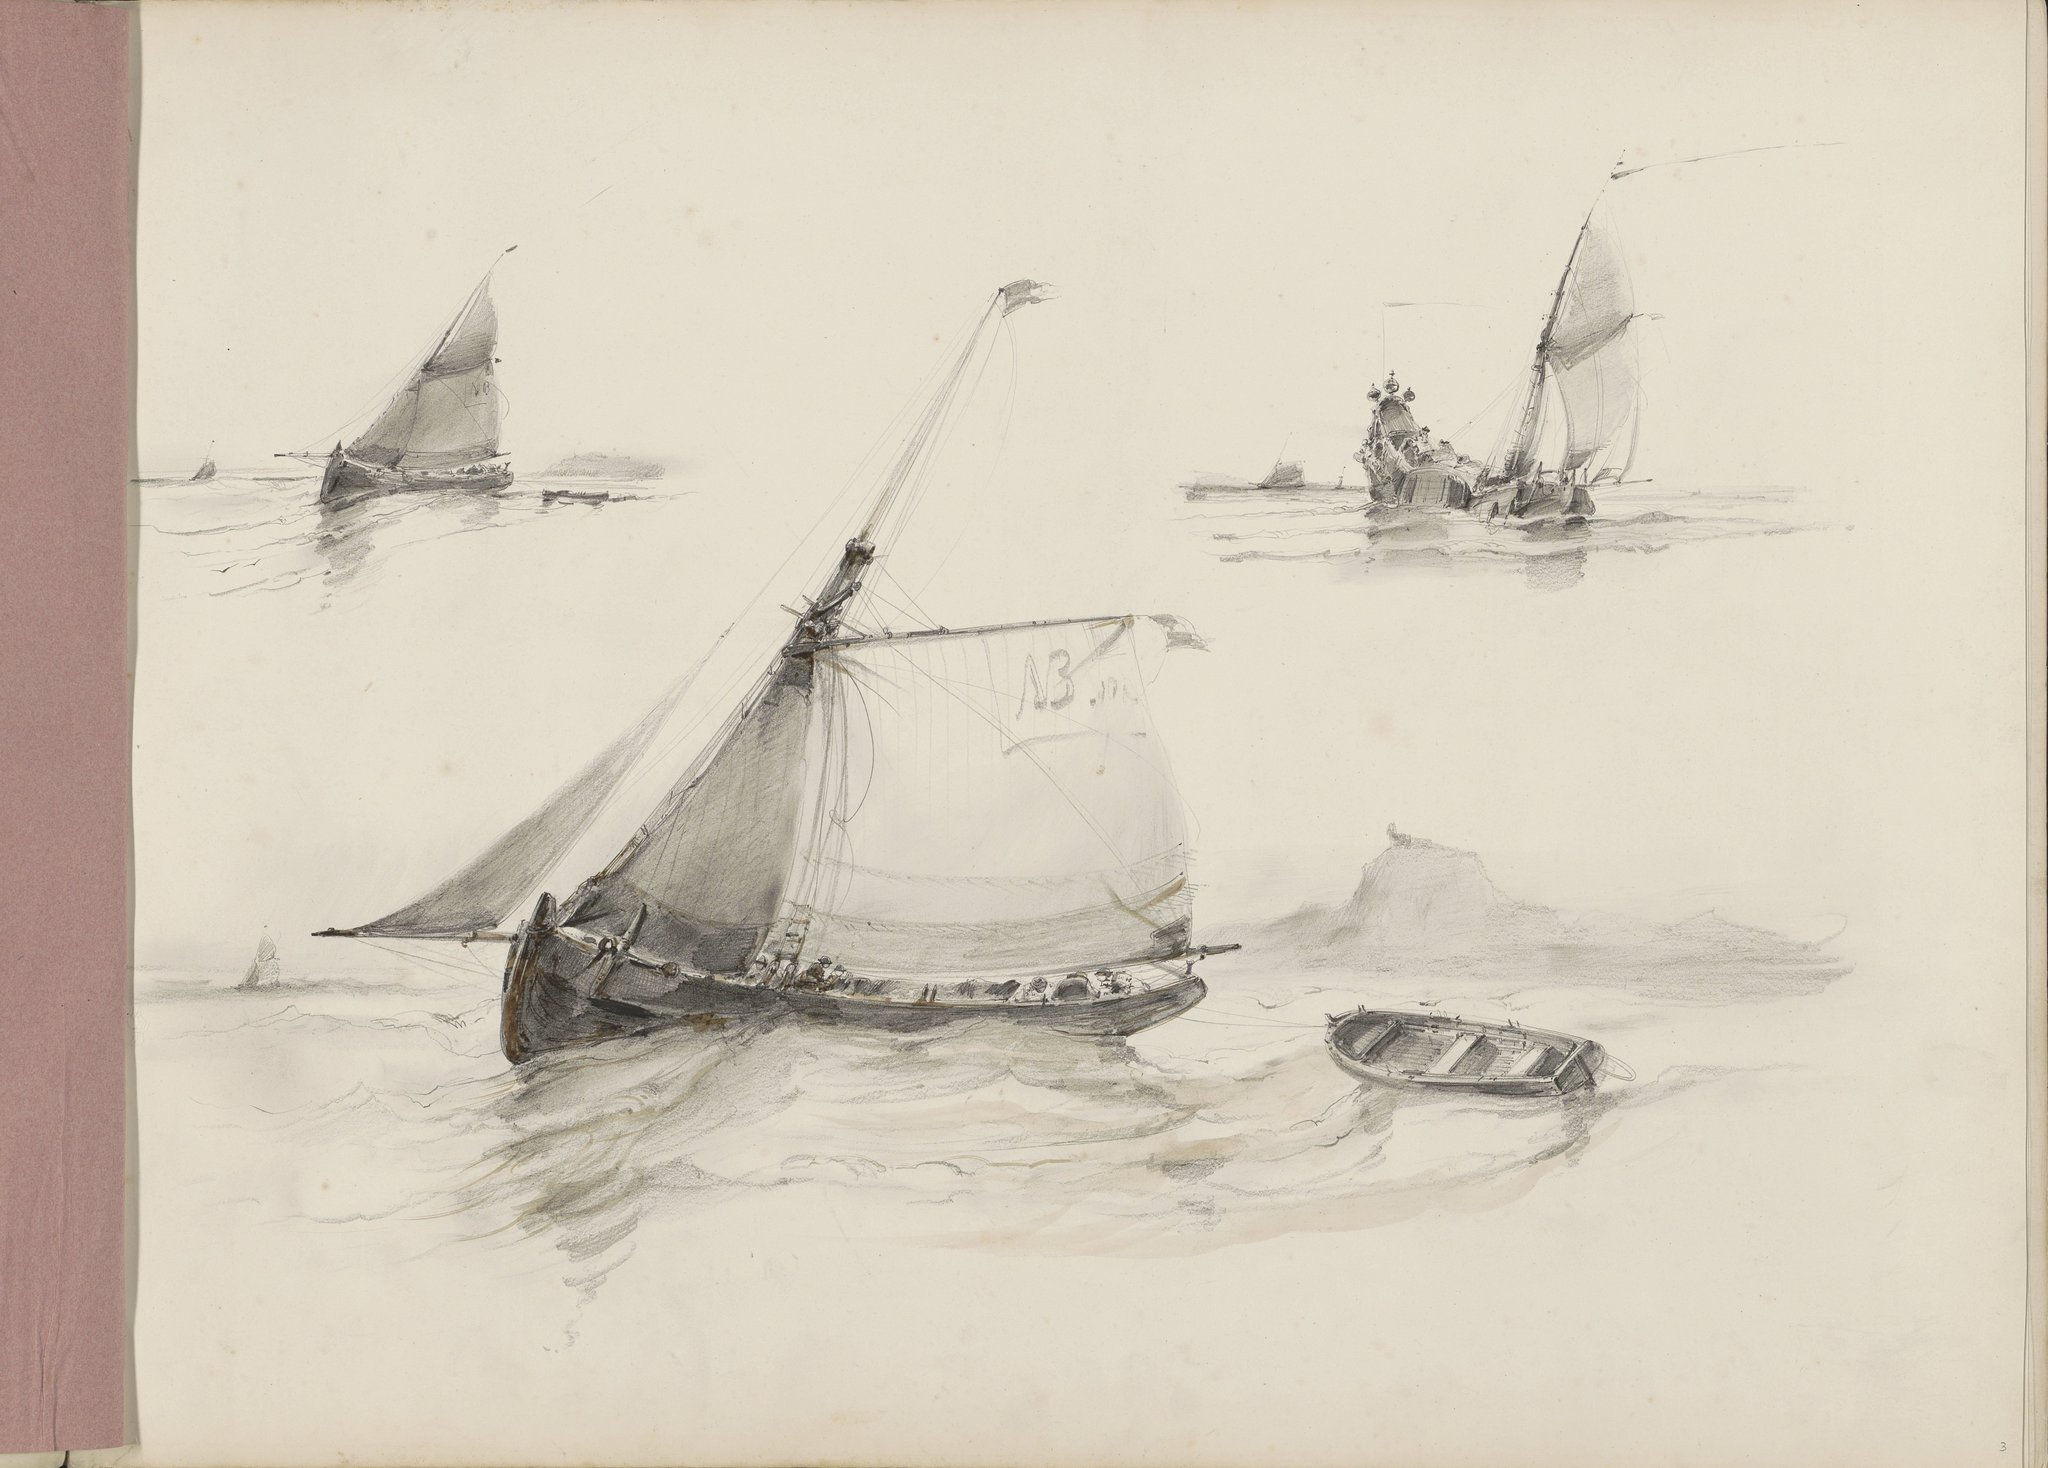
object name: sketchbook leaf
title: Drie zeegezichten, waaronder een zeilschip voor een rots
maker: albertus van beest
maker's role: draughtsman, print maker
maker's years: 1820-1860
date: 1830-1860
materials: paper, pencil, watercolor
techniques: brush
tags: sailing-ship, sailing-boat, rocky coast, landscapes with waters, waterscapes, seascapes (in the temperate zone)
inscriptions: monogram: ‘AB. 18[...]’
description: Blad 3 recto uit een schetsboek met 10 bladen.